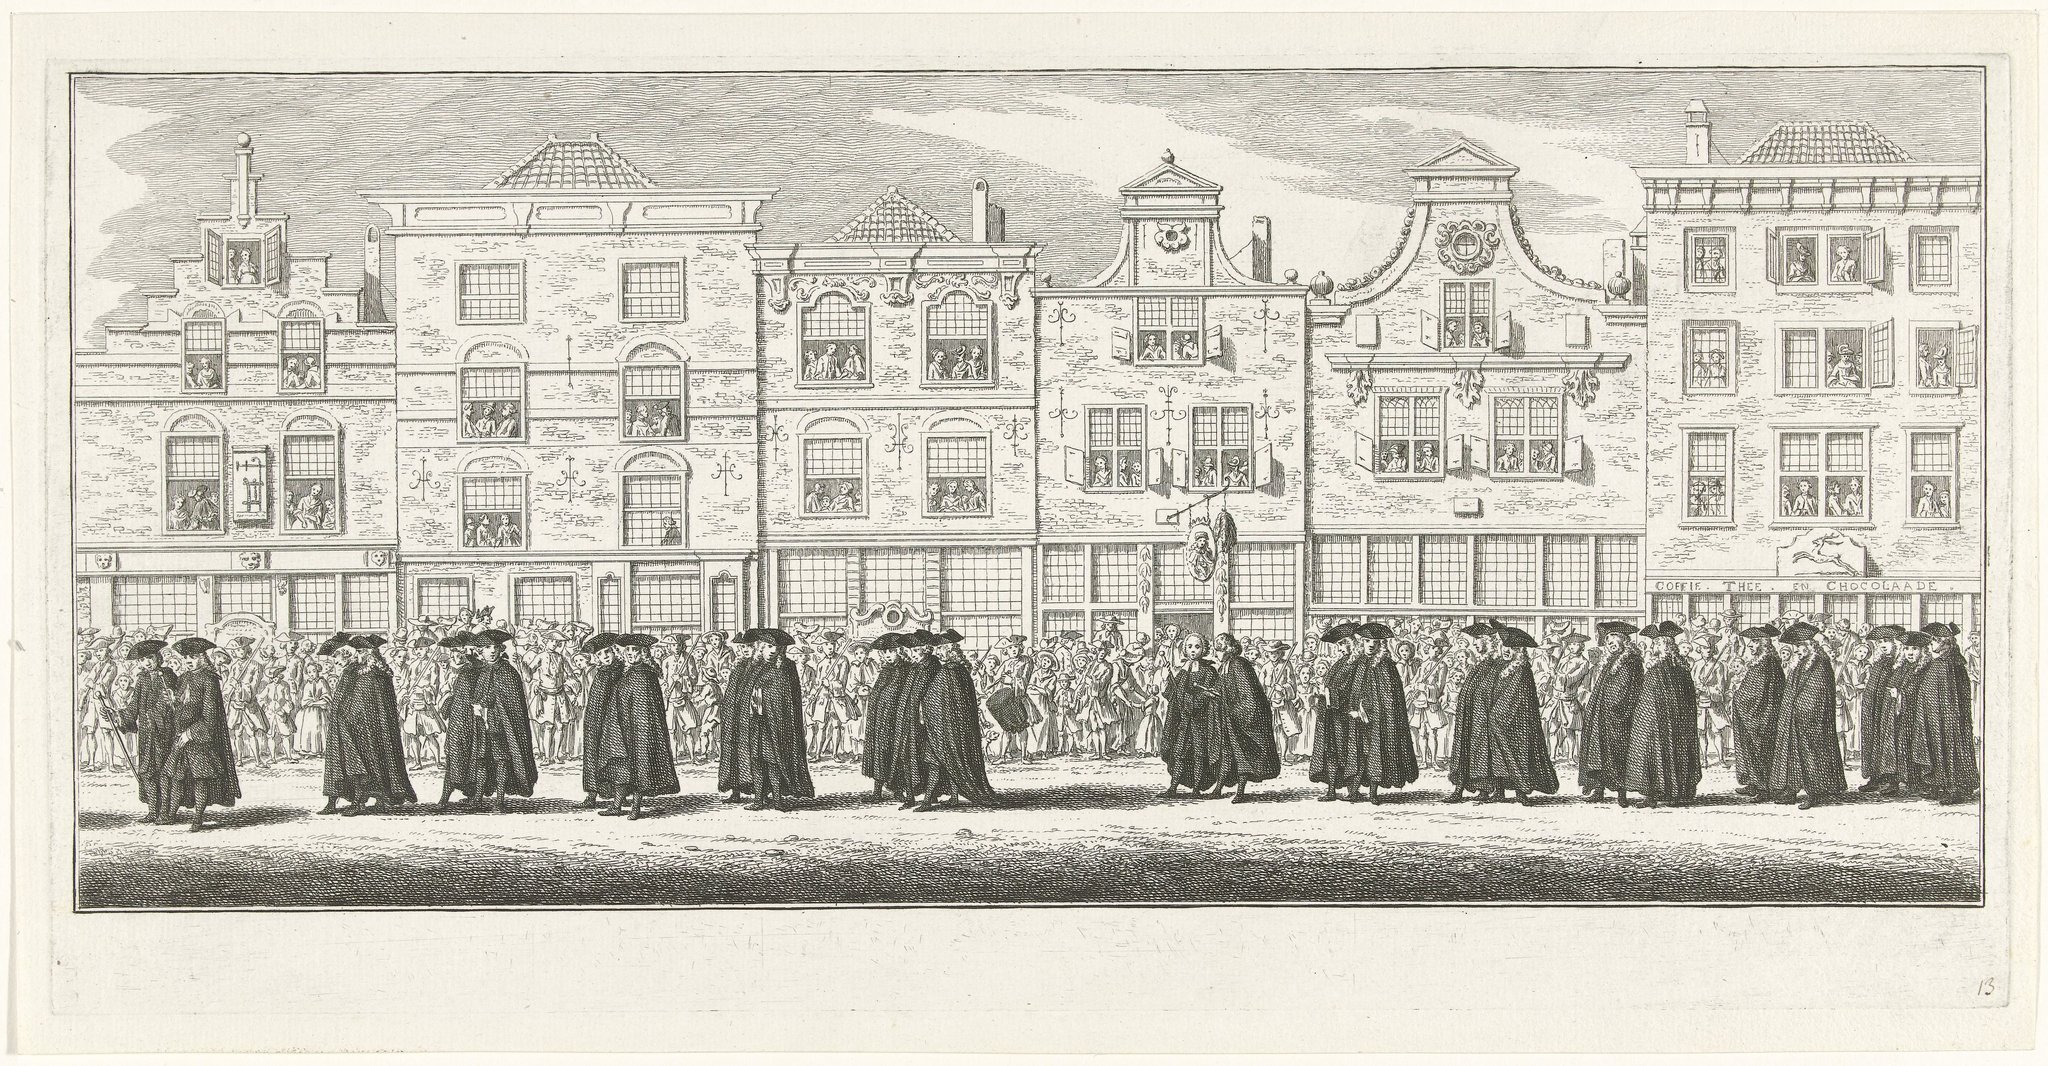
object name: print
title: Lijkstoet van prinses Anna van Hannover te Delft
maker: simon fokke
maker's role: draughtsman, print maker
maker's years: 1712-1784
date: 1759-1761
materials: paper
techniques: etching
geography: amsterdam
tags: anna van hannover, cortege, funeral procession, delft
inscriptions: collector's mark: Lugt 2228, serial number: ‘13’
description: Leden van de juridische staf en hofhouding van de prinses. Onderdeel van een serie van 16 platen in etsdruk van de lijkstatie van de op 23 februari 1759 te Delft begraven prinses Anna van Hannover.